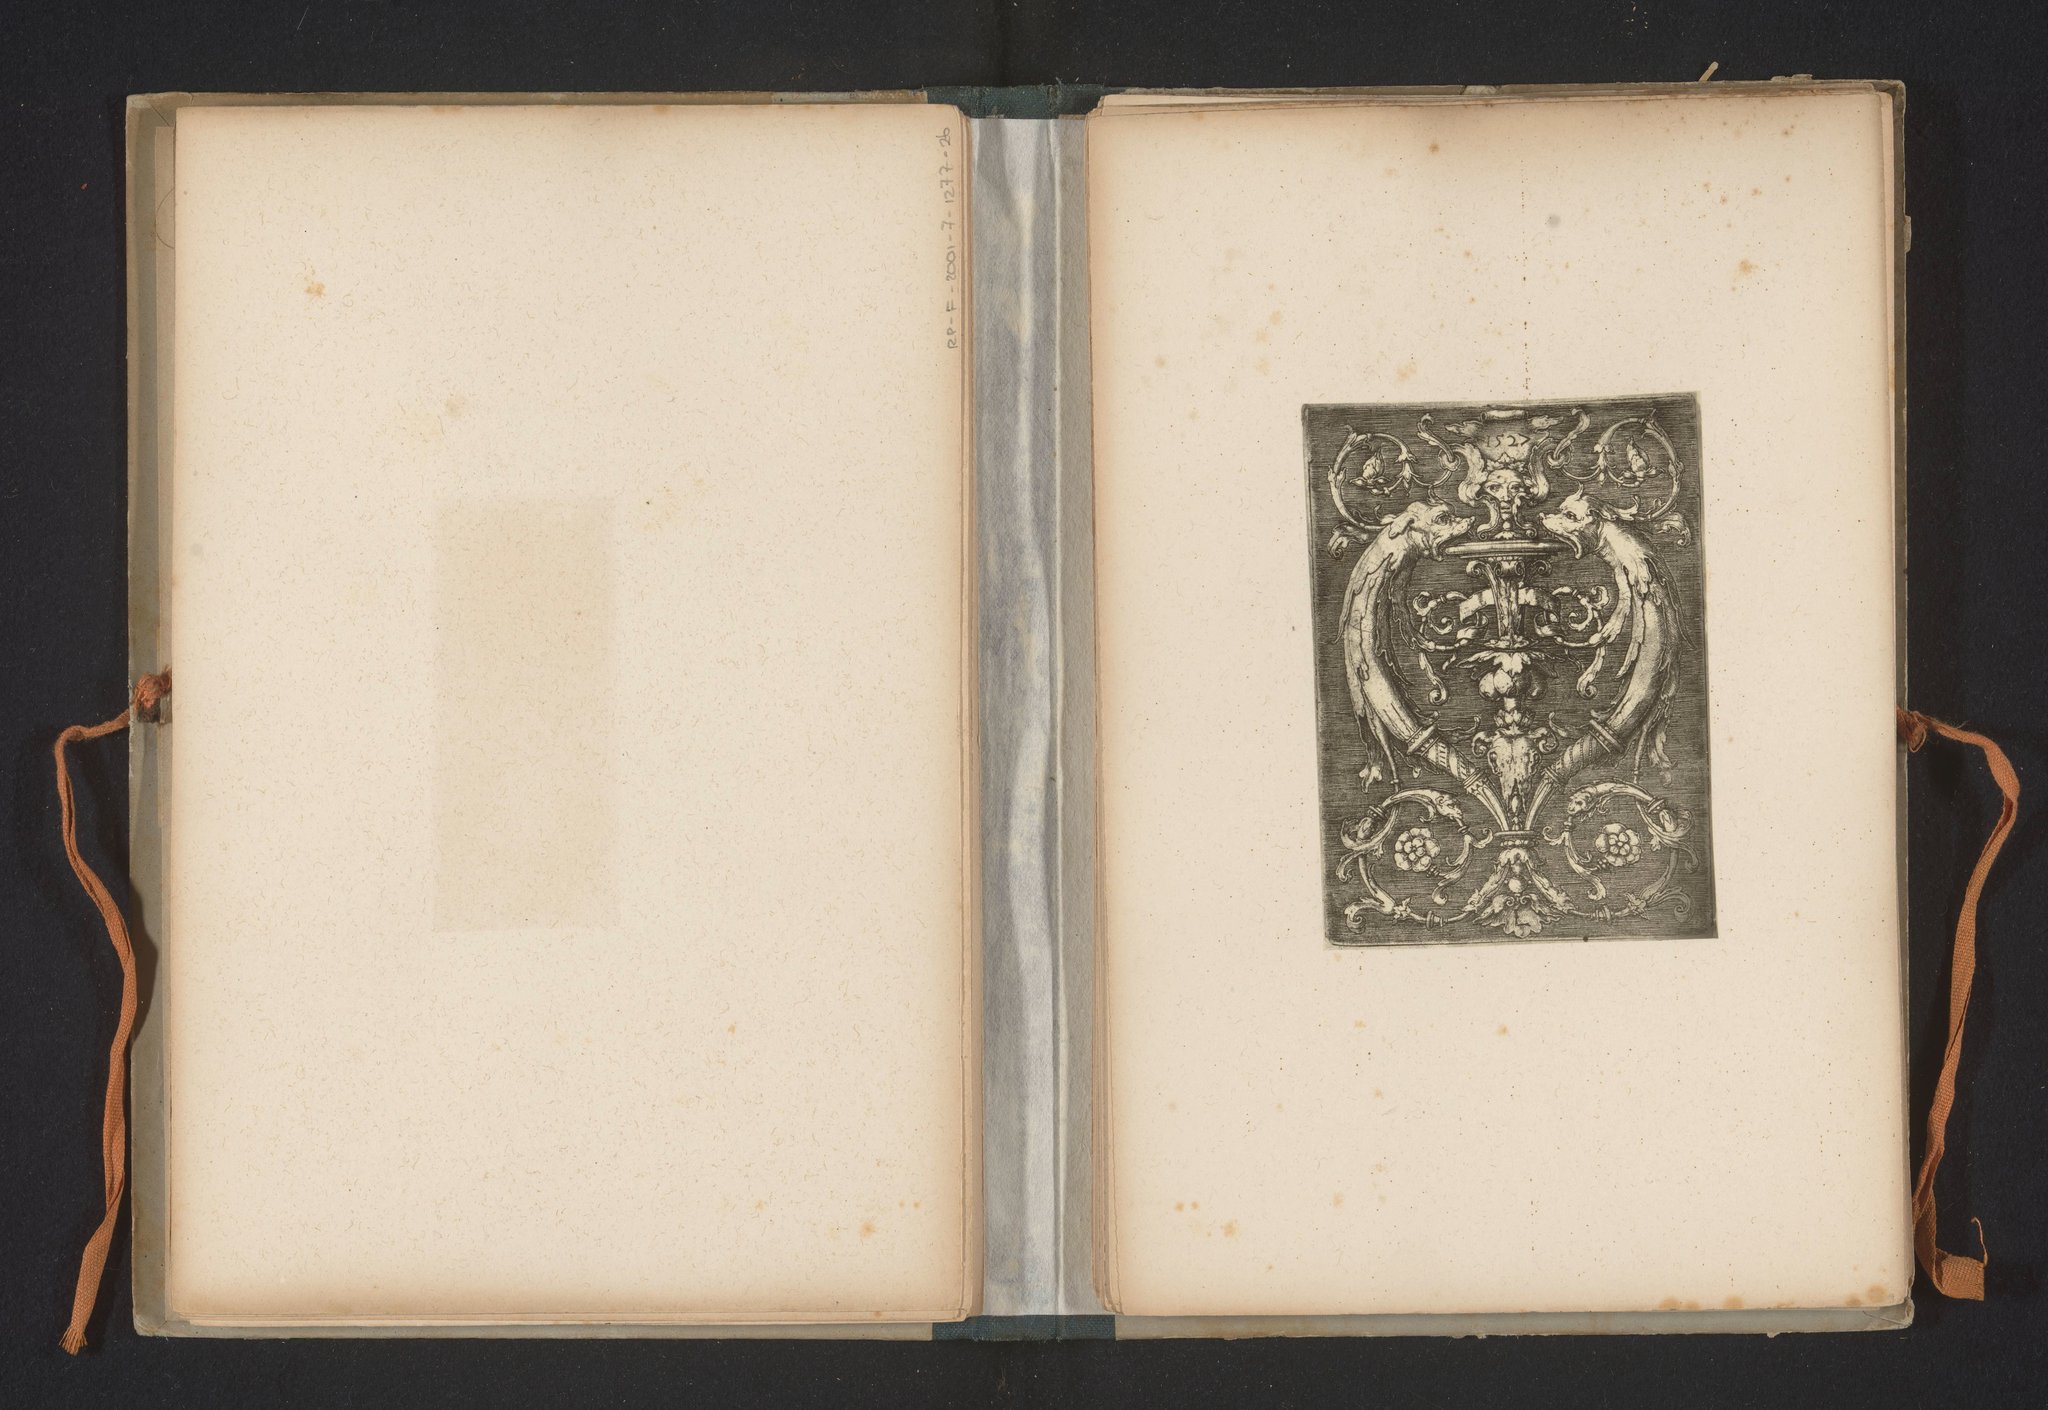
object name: reproduction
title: Reproductie van een prent van een ornament met twee dolfijnen door Lucas van Leyden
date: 1866-1871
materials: paper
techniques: woodburytype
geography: brussels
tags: dolphin ~ ornament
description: Deze prent maakt deel uit van een omslag met 57 prenten op 54 bladen.